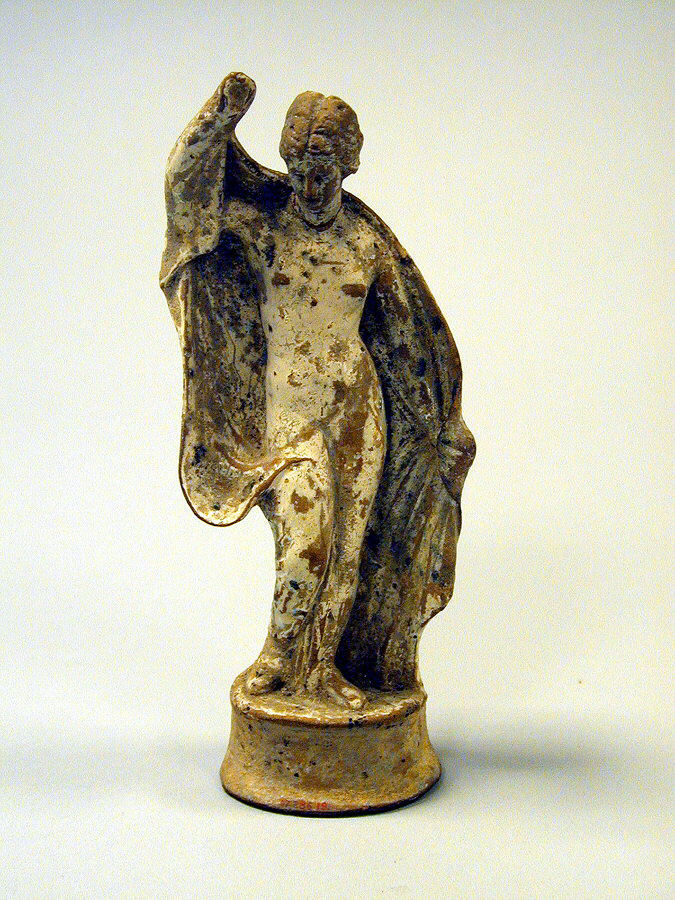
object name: statuette of a woman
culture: greek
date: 300-101 BCE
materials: terracotta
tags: women